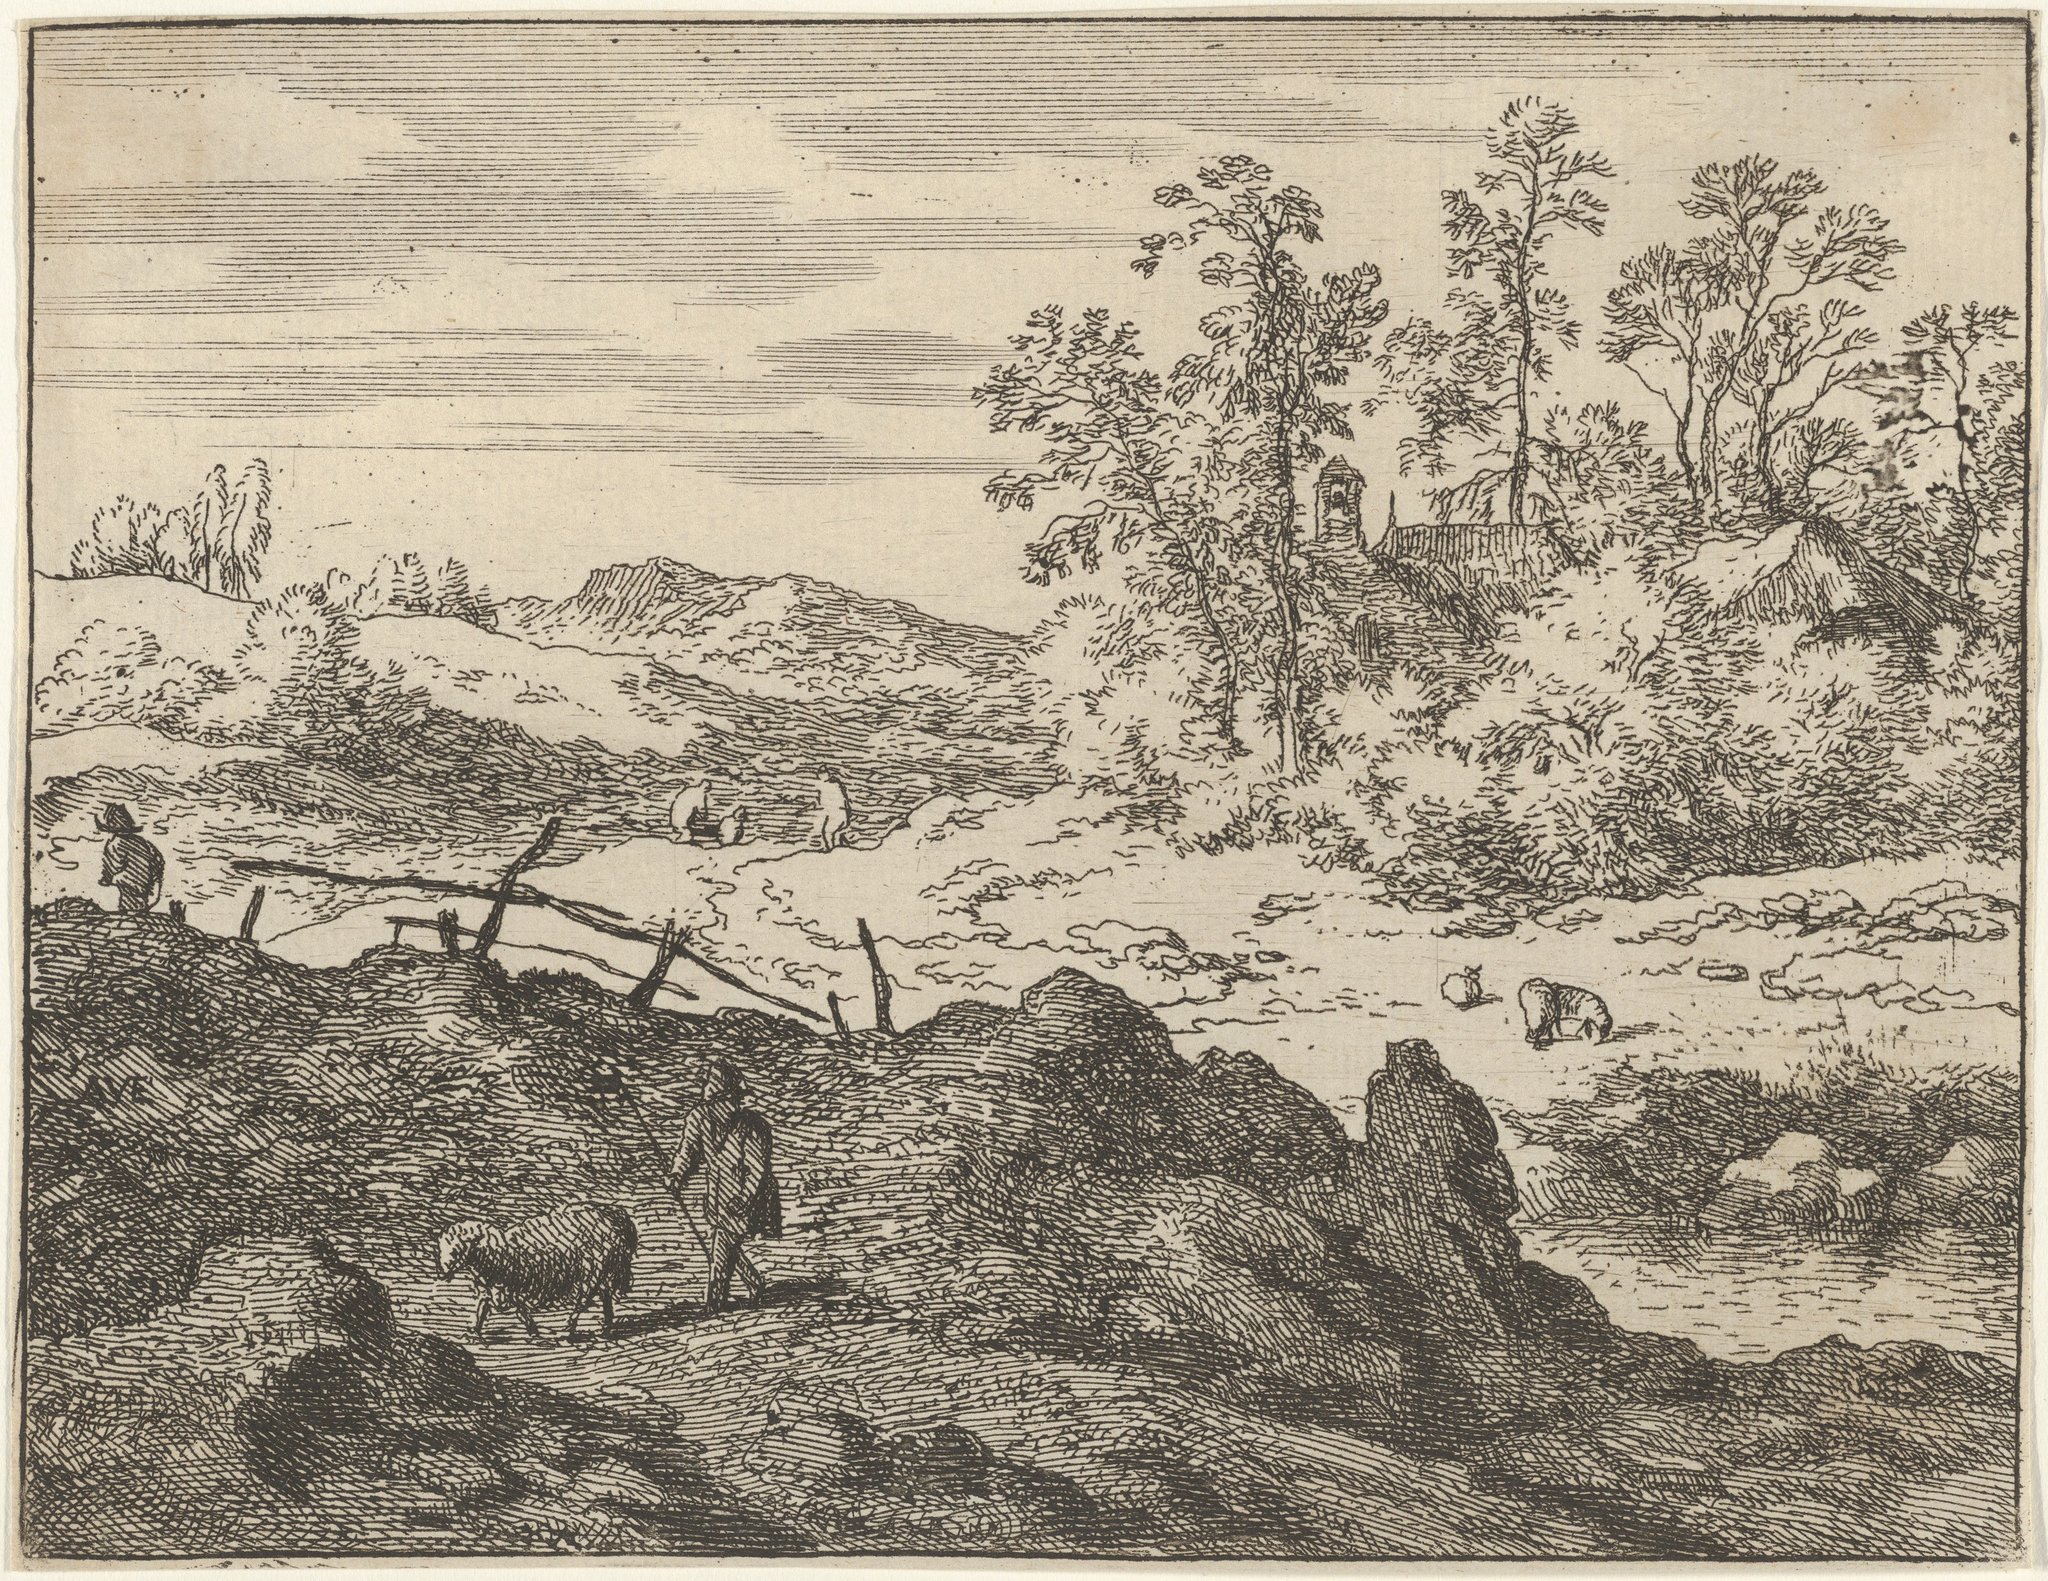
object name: print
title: The Shepherd and the Lamb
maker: allart van everdingen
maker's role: artist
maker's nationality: dutch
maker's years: 1621-1675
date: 1621-1675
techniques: engraving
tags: lambs,trees,shepherds